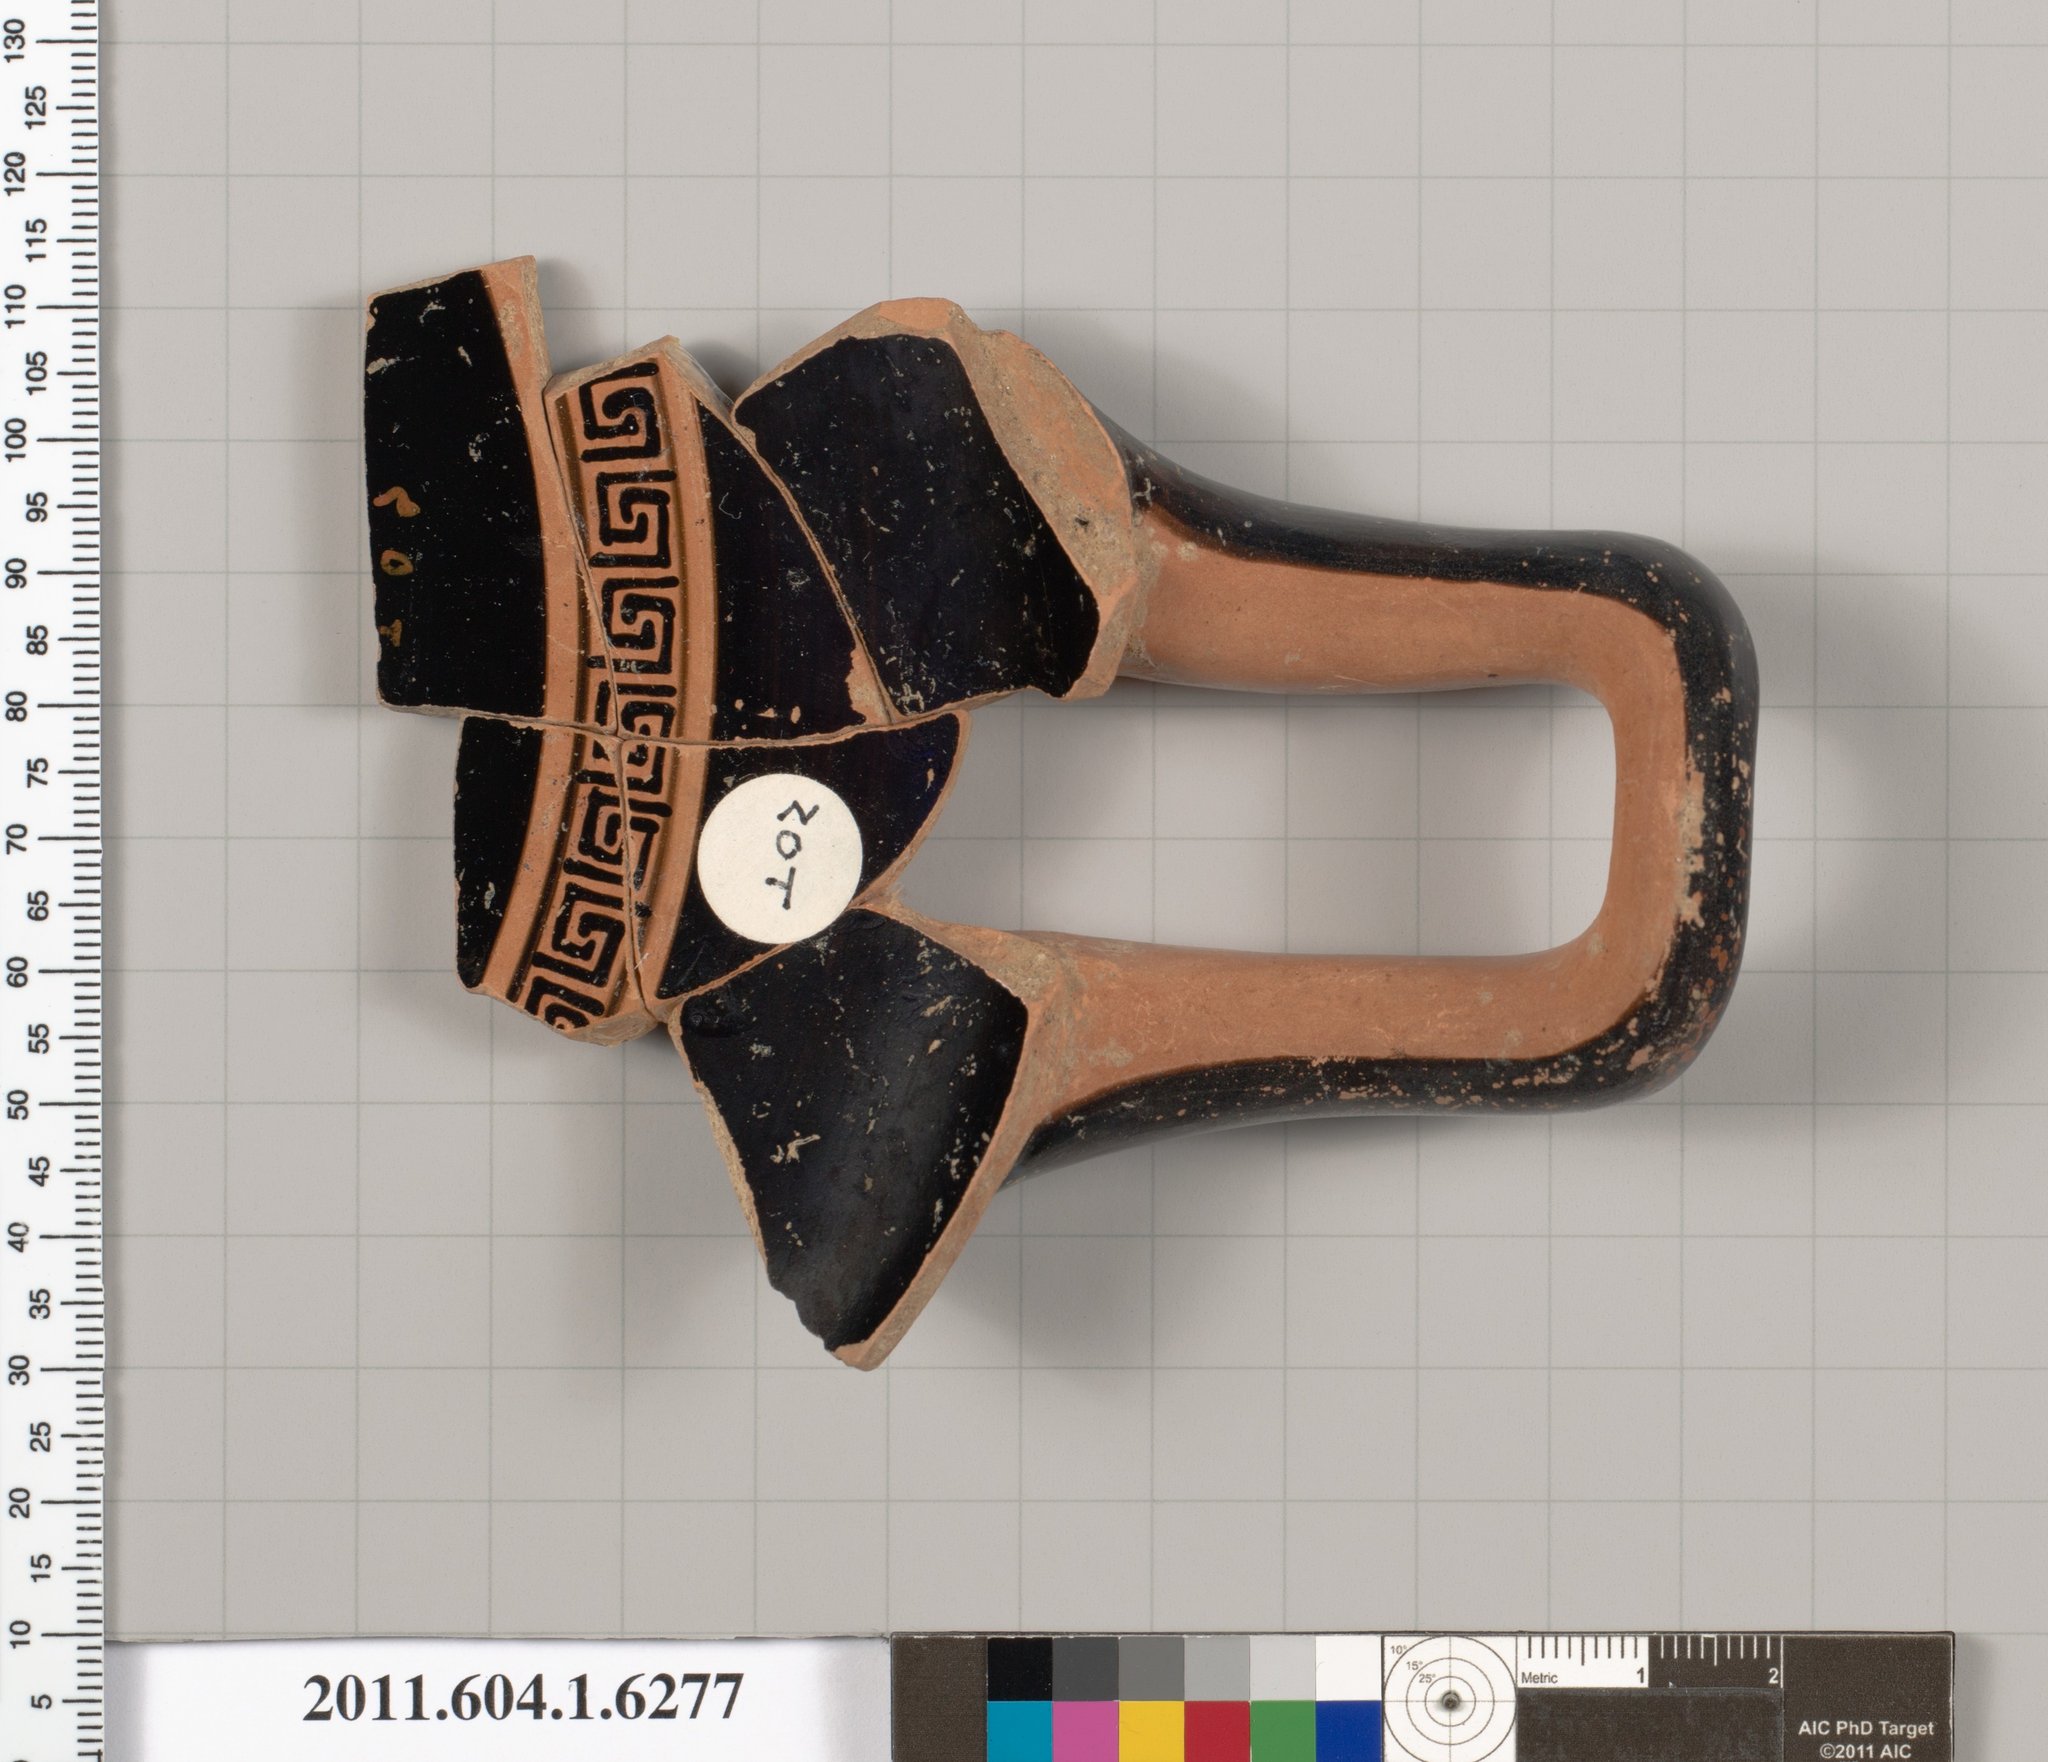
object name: kylix fragment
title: Terracotta fragment of a kylix (drinking cup)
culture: greek, attic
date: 500-480 BCE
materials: terracotta